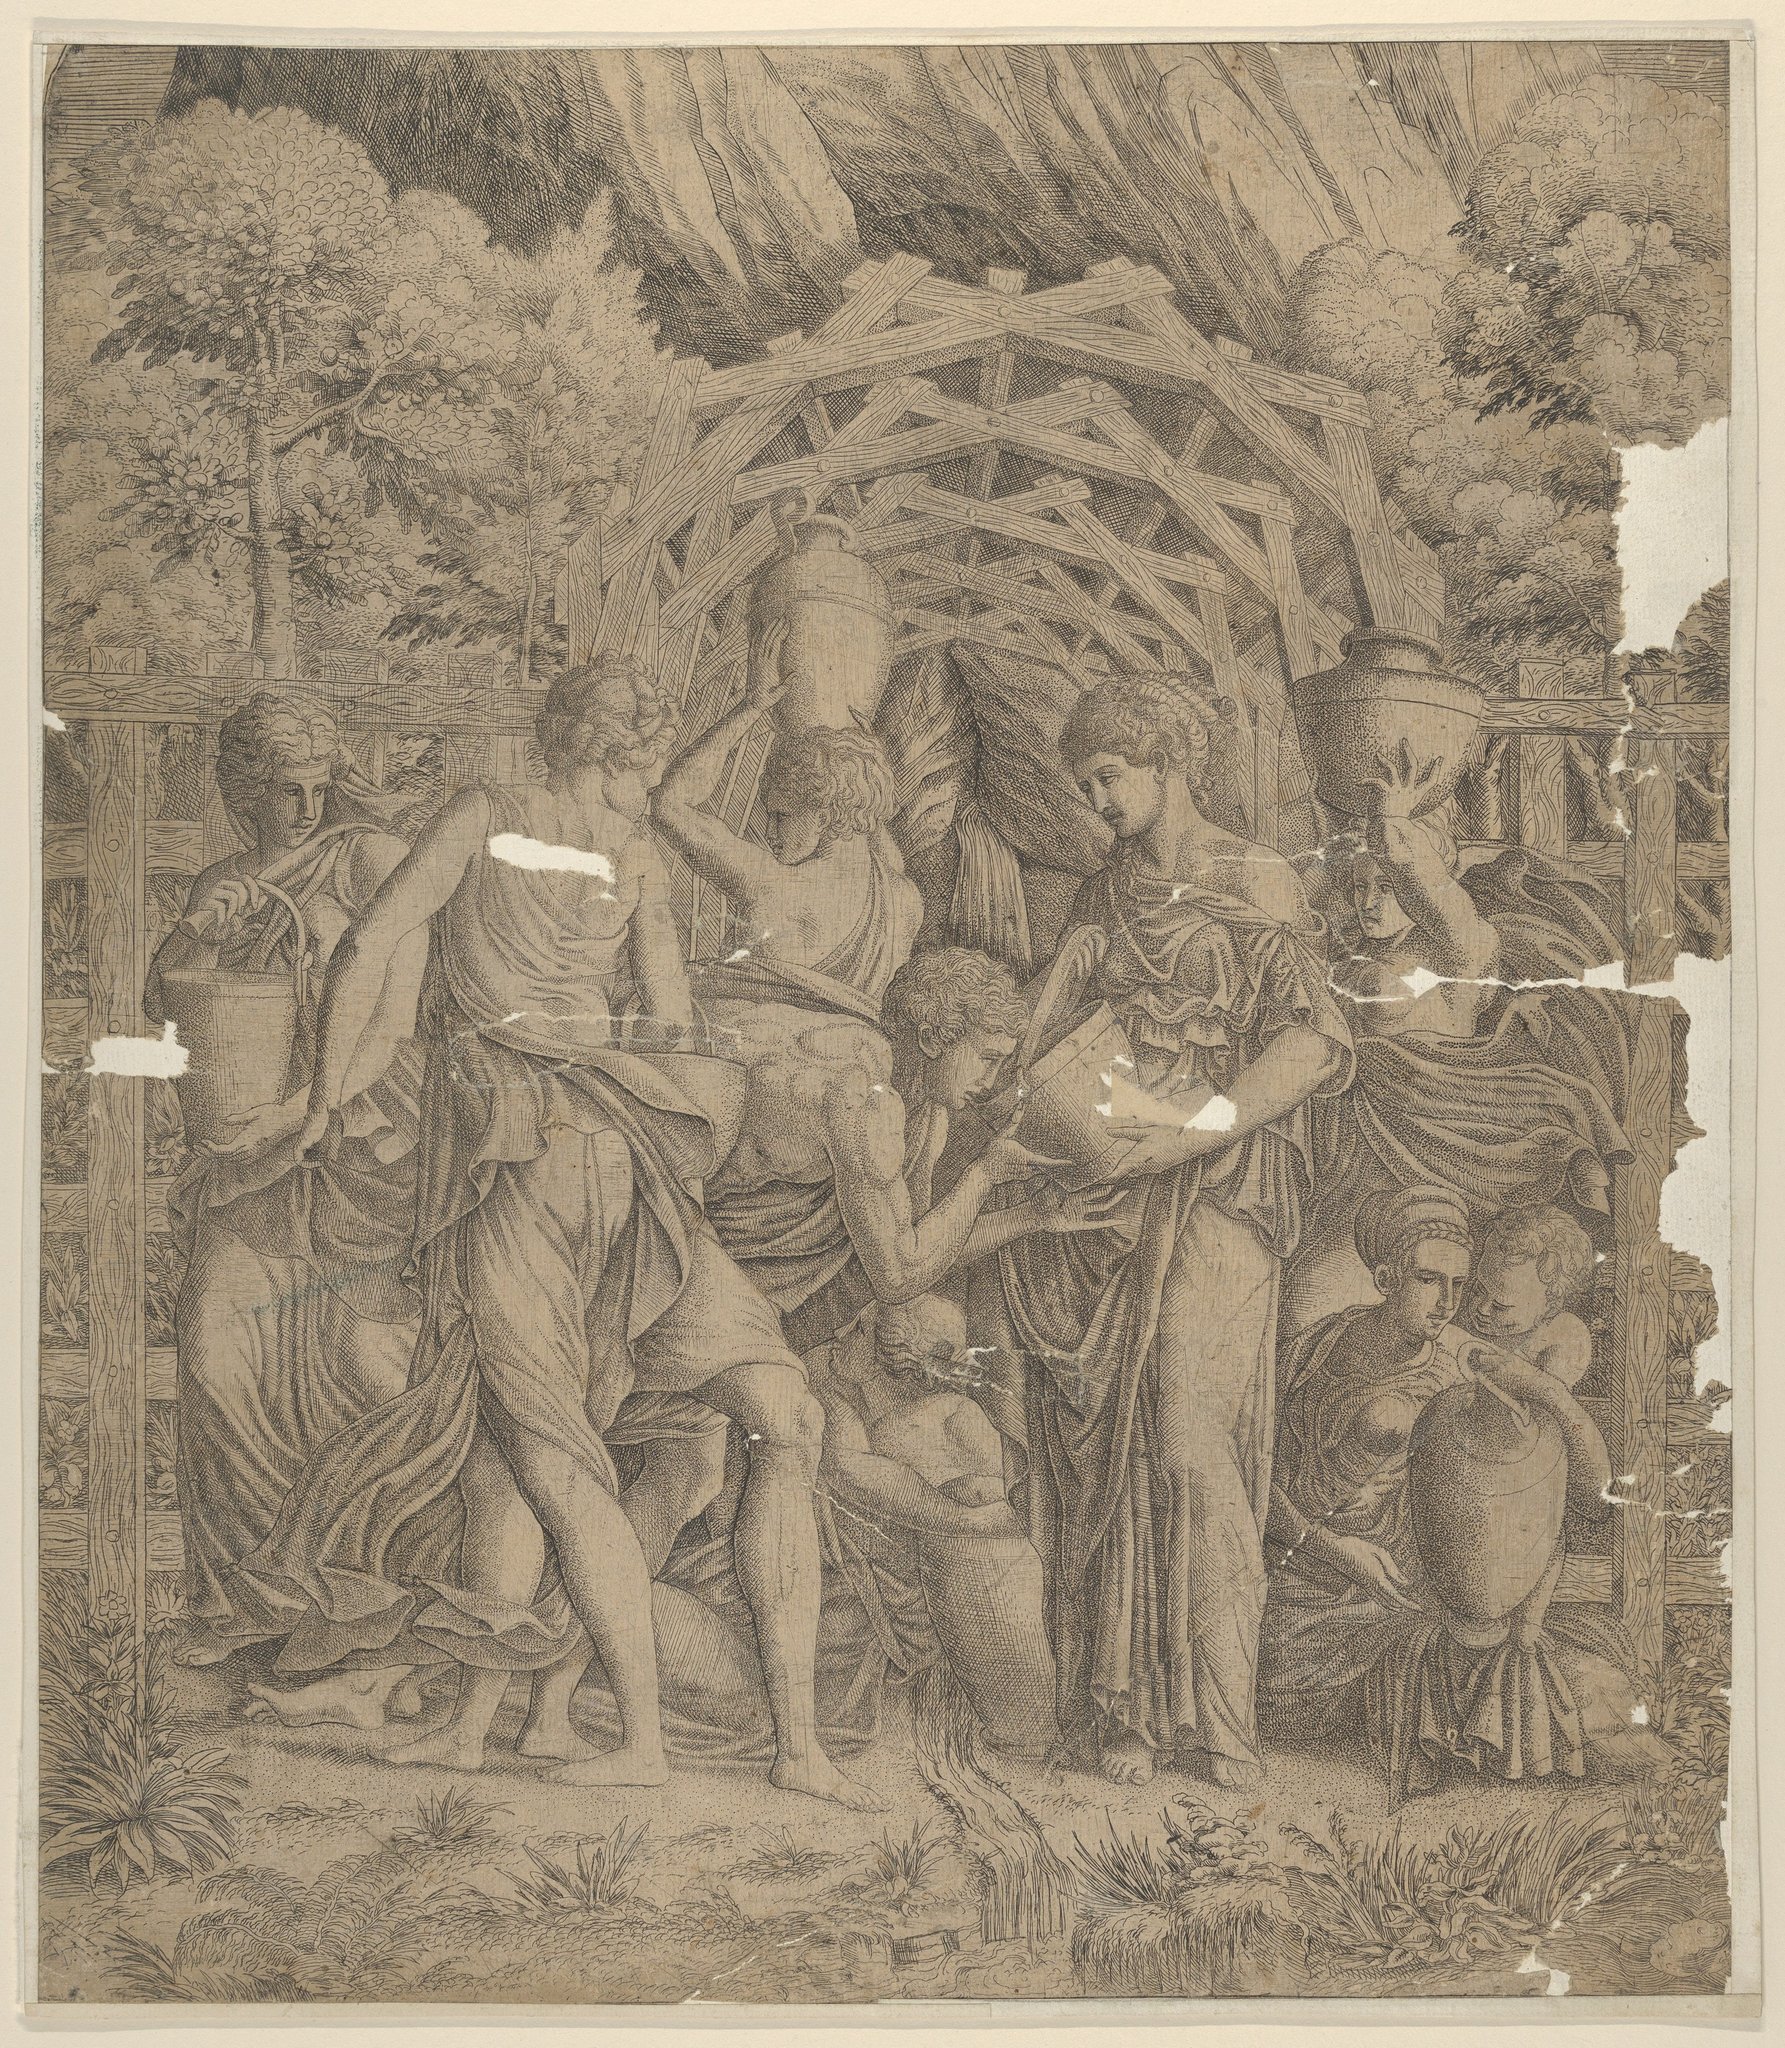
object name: print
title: Rebecca and Eliezer at the Well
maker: master iqv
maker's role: artist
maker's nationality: french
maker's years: 1500-1600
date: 1542-1545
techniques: etching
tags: wells,children,men,women